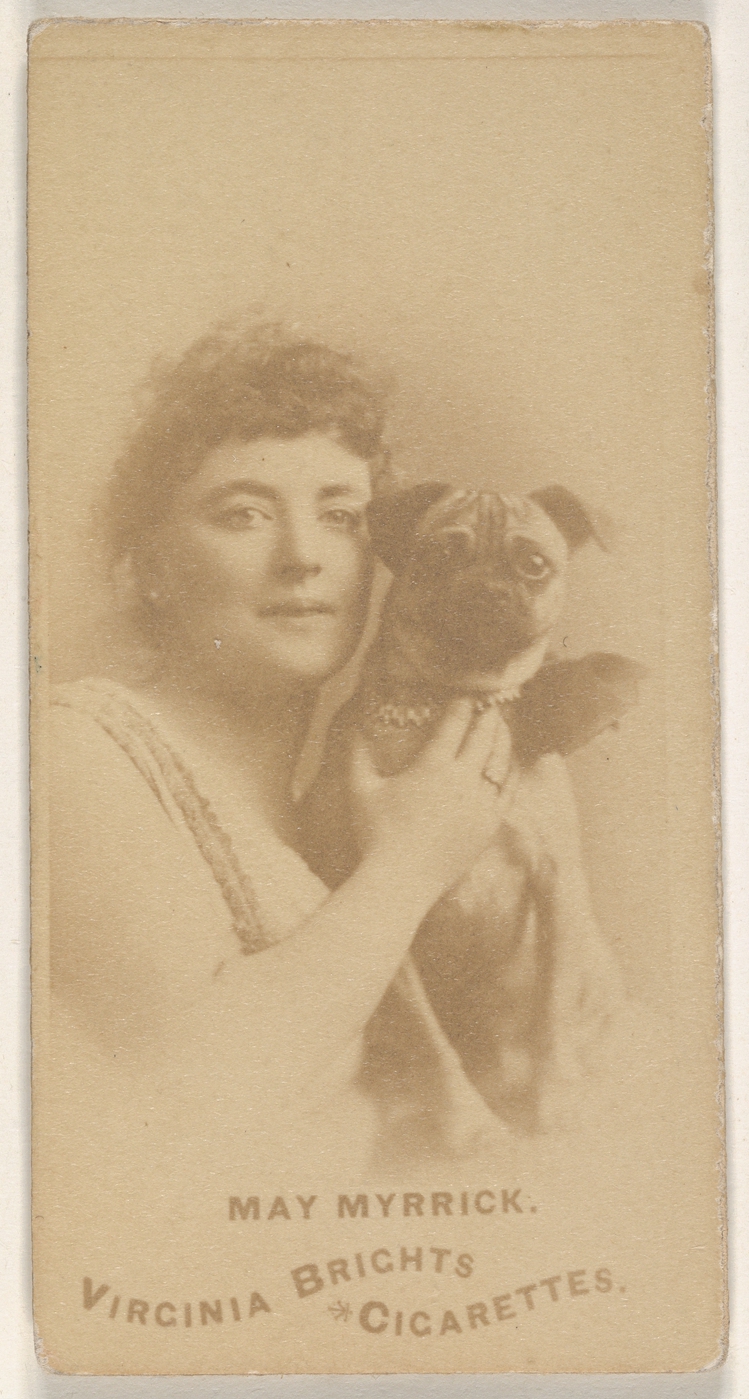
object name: photograph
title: May Myrrick, from the Actors and Actresses series (N45, Type 1) for Virginia Brights Cigarettes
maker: allen & ginter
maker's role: publisher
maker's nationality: american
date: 1888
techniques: albumen silver print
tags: portraits,women,dogs,actresses